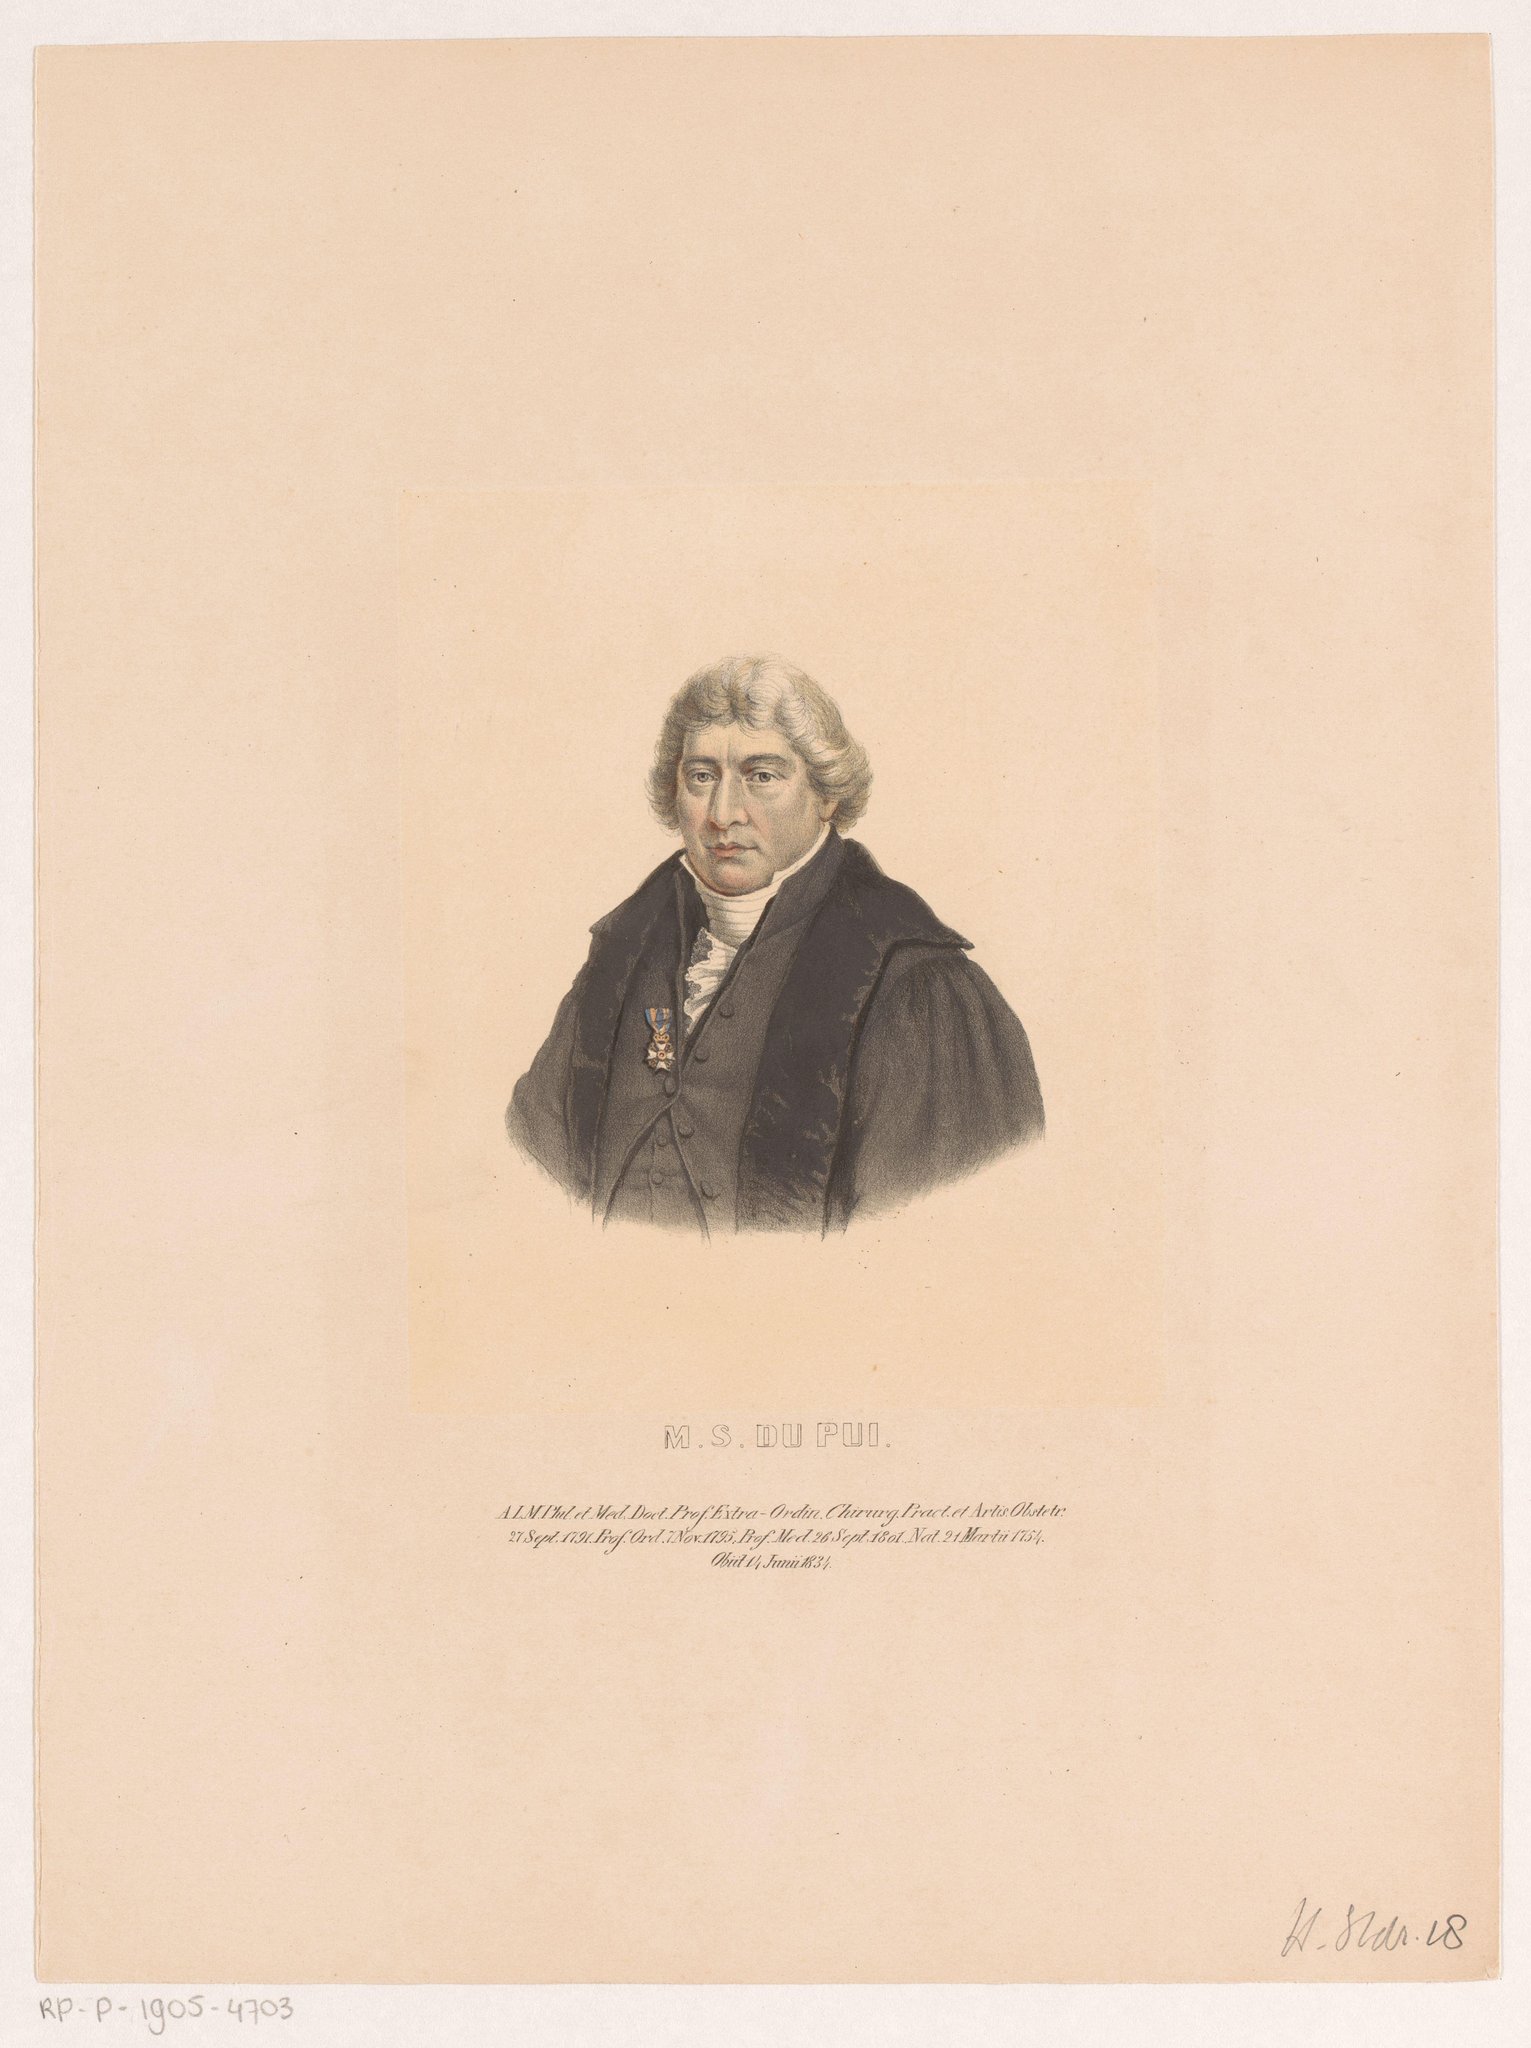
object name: print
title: M.S. du Pui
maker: leendert springer (i)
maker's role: draughtsman, painter, print maker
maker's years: 1789-1871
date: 1850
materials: paper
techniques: lithograph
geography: leiden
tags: enkhuizen, leiden, historical persons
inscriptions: collector's mark: Lugt 2228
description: Prent uit: Springer, Leendert. Galerij van hoogleeraren aan de Hoogeschool te Leijden, naar de oorspronkelijke afbeeldsels op de Senaat-zaal aldaar berustende. Leiden: Springer, Leendert., s.a. [circa 1850].